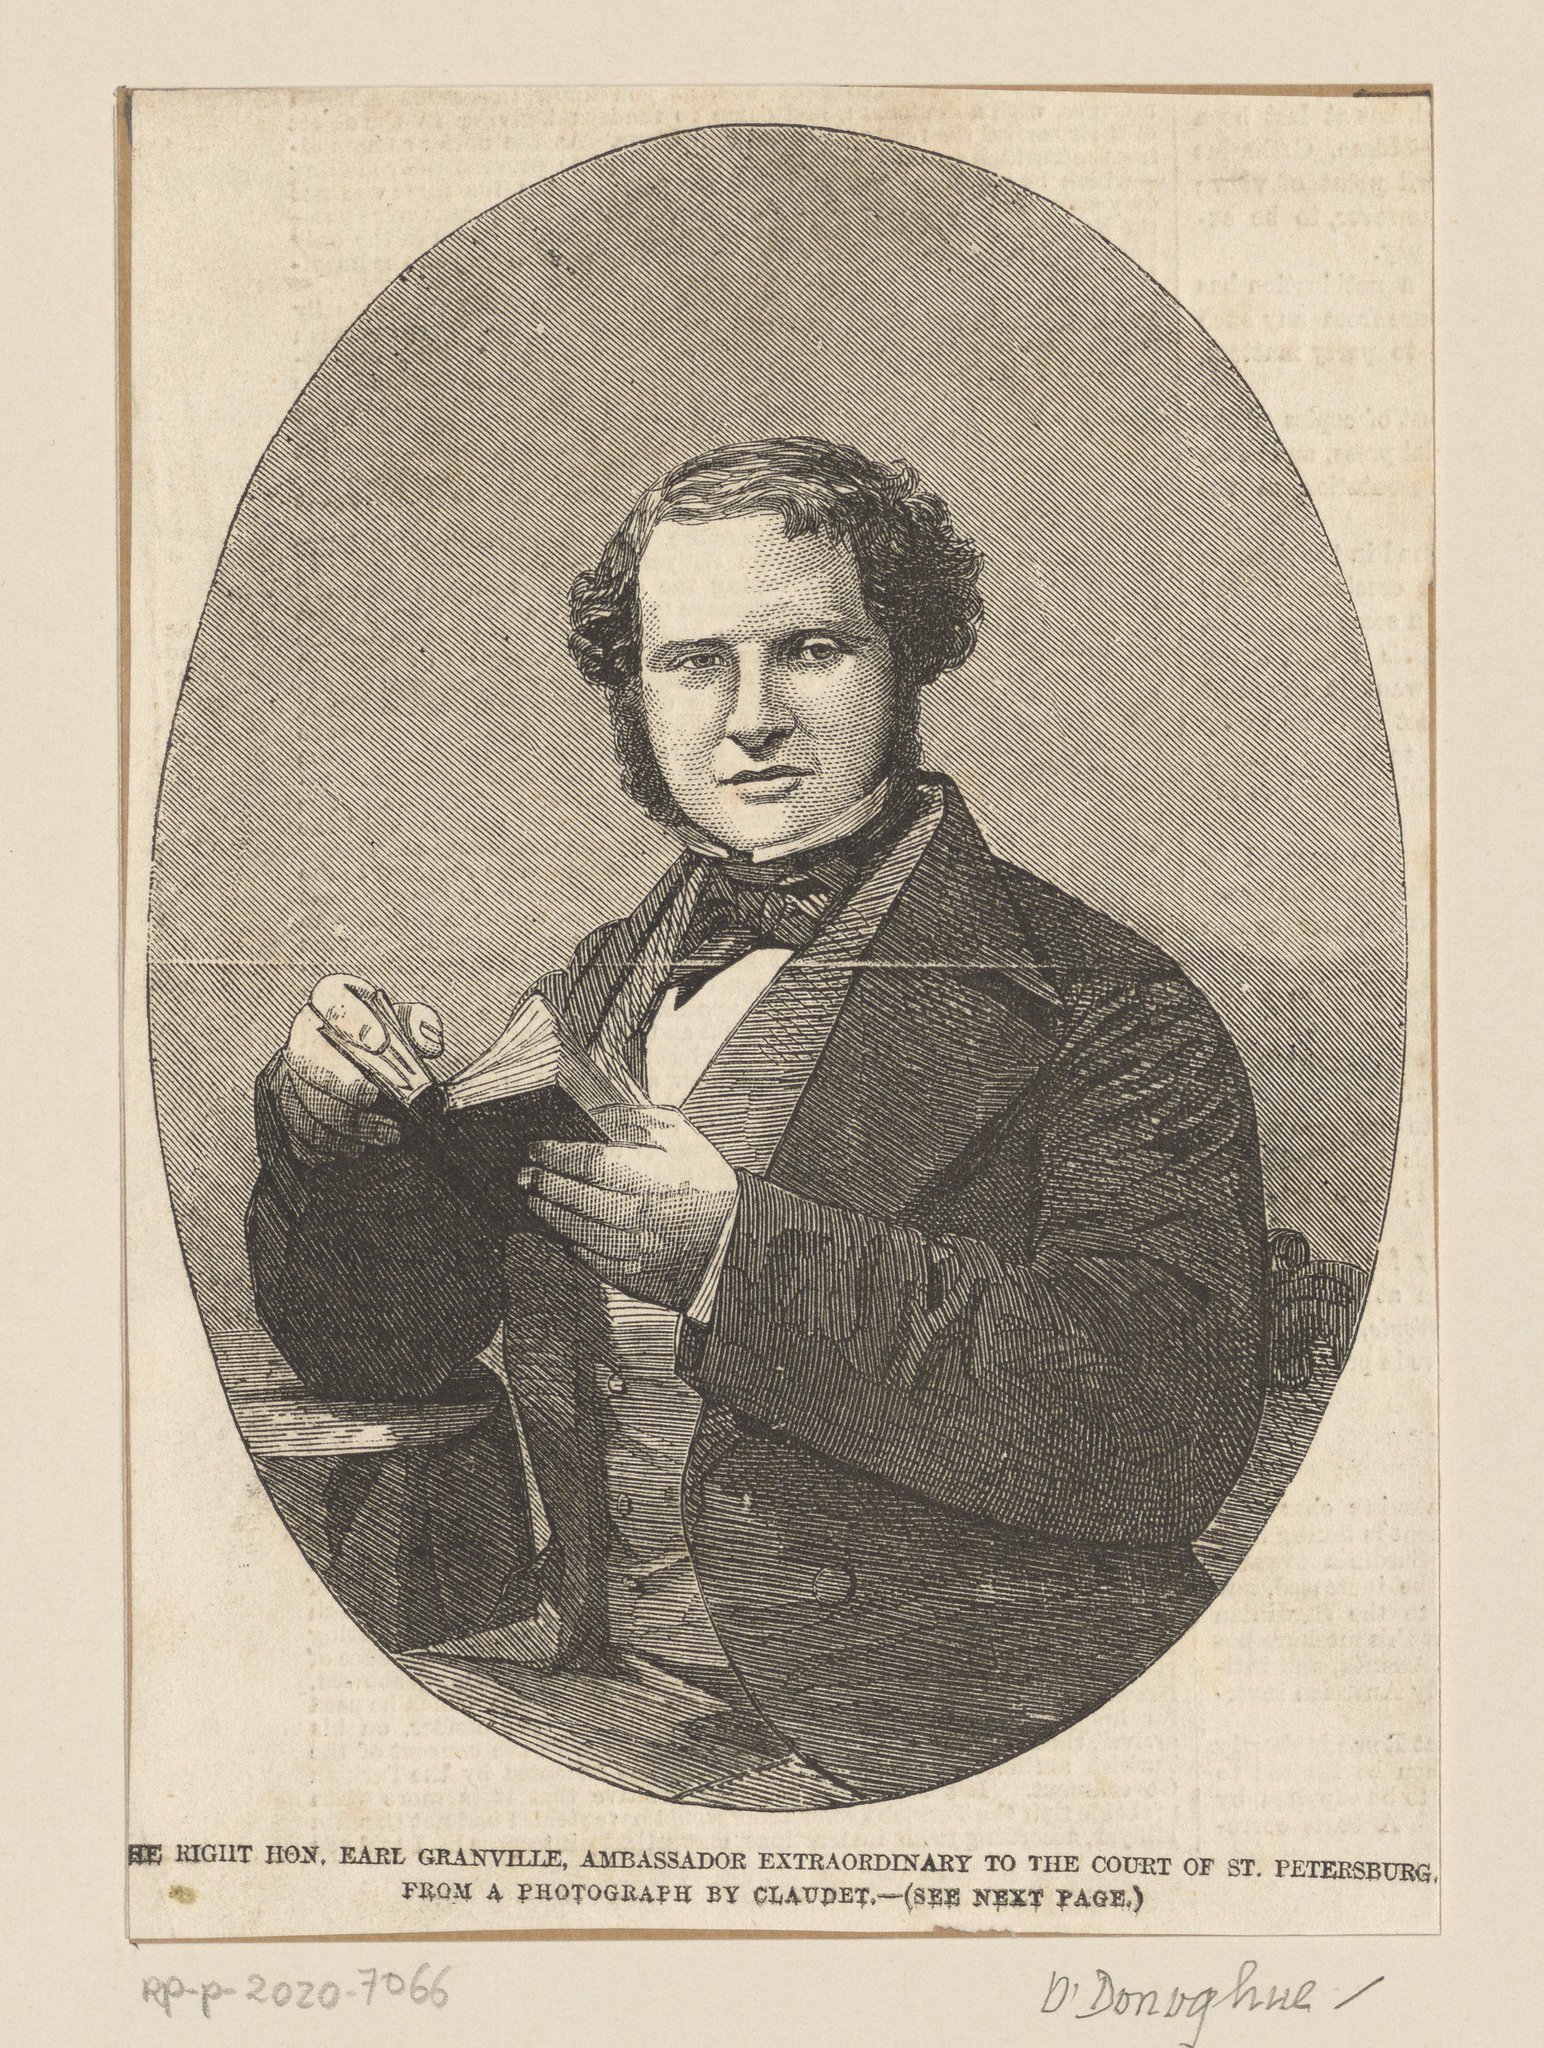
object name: print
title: Portret van Granville Leveson-Gower, 1e hertog van Granville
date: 1856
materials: paper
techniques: letterpress printing, engraving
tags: historical persons, diplomacy, diplomat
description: Prent uit: The Illustrated London News, [1856].